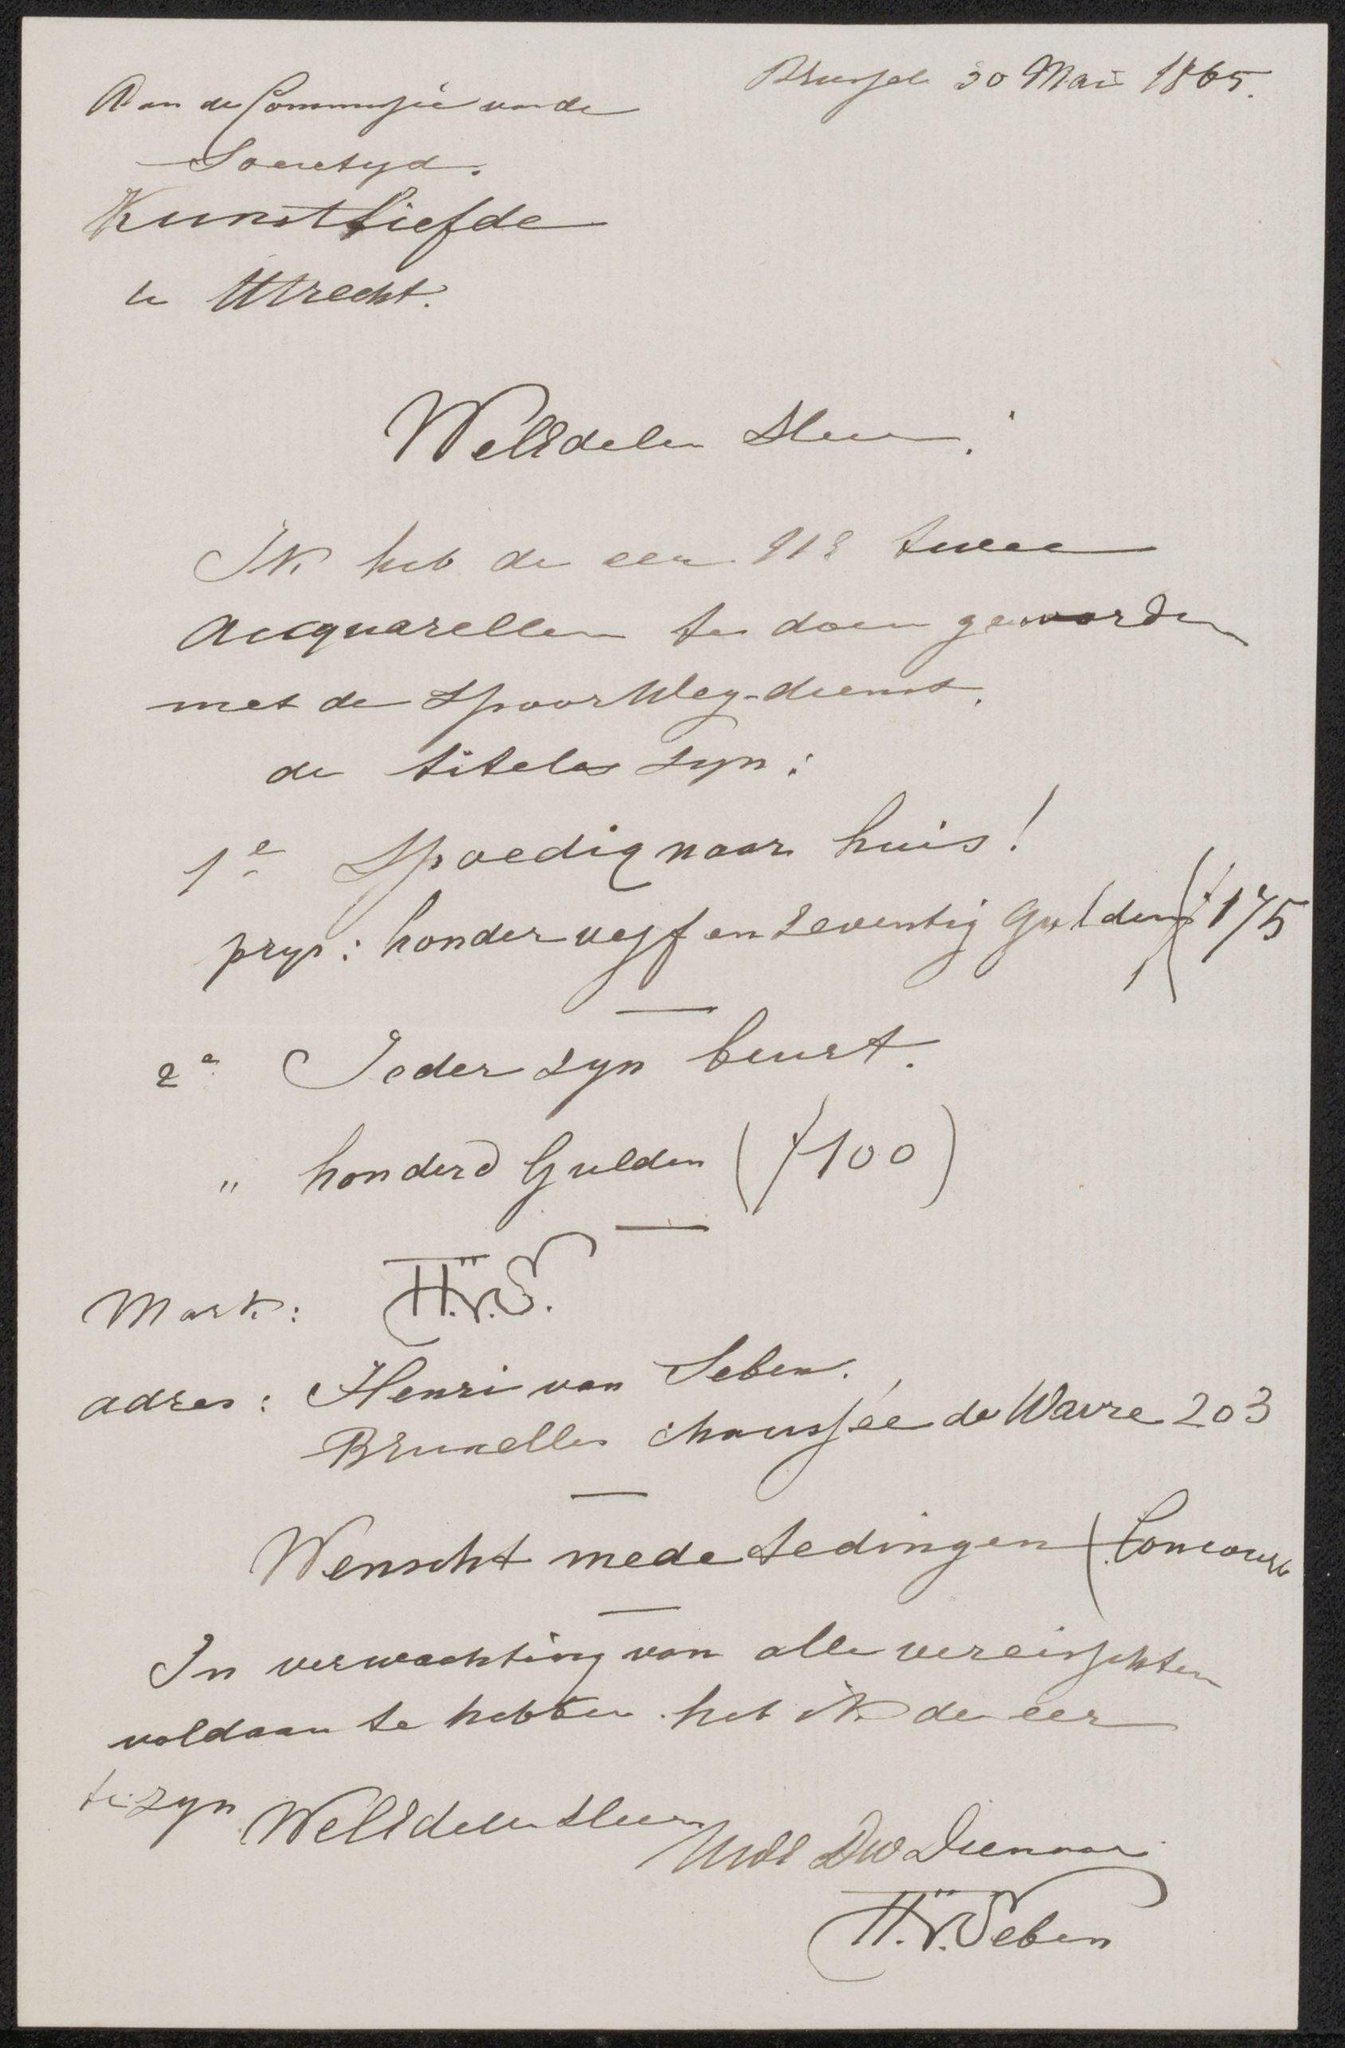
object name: letter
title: Brief aan Genootschap Kunstliefde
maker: henri van seben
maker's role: print maker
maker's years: 1825-1913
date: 1865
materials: ink, paper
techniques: pen, writing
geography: brussels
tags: drawing, money